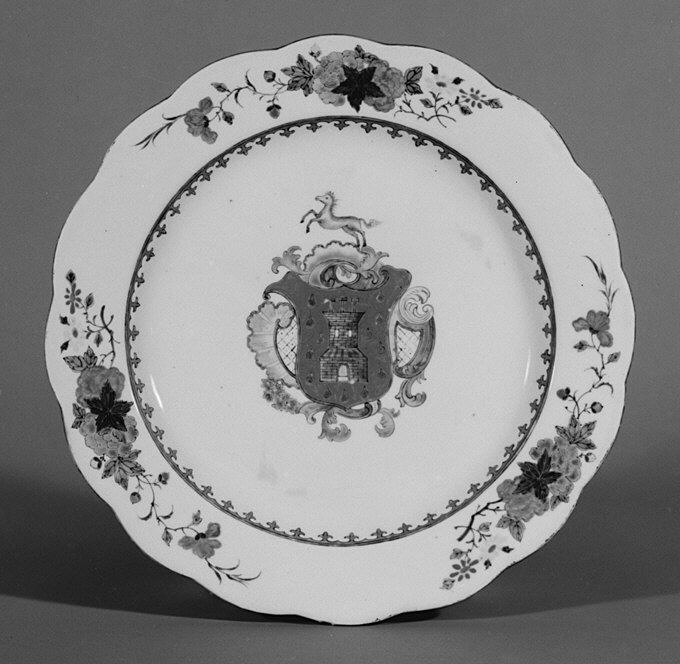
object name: plate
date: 1765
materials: hard paste porcelain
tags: flowers,coat of arms